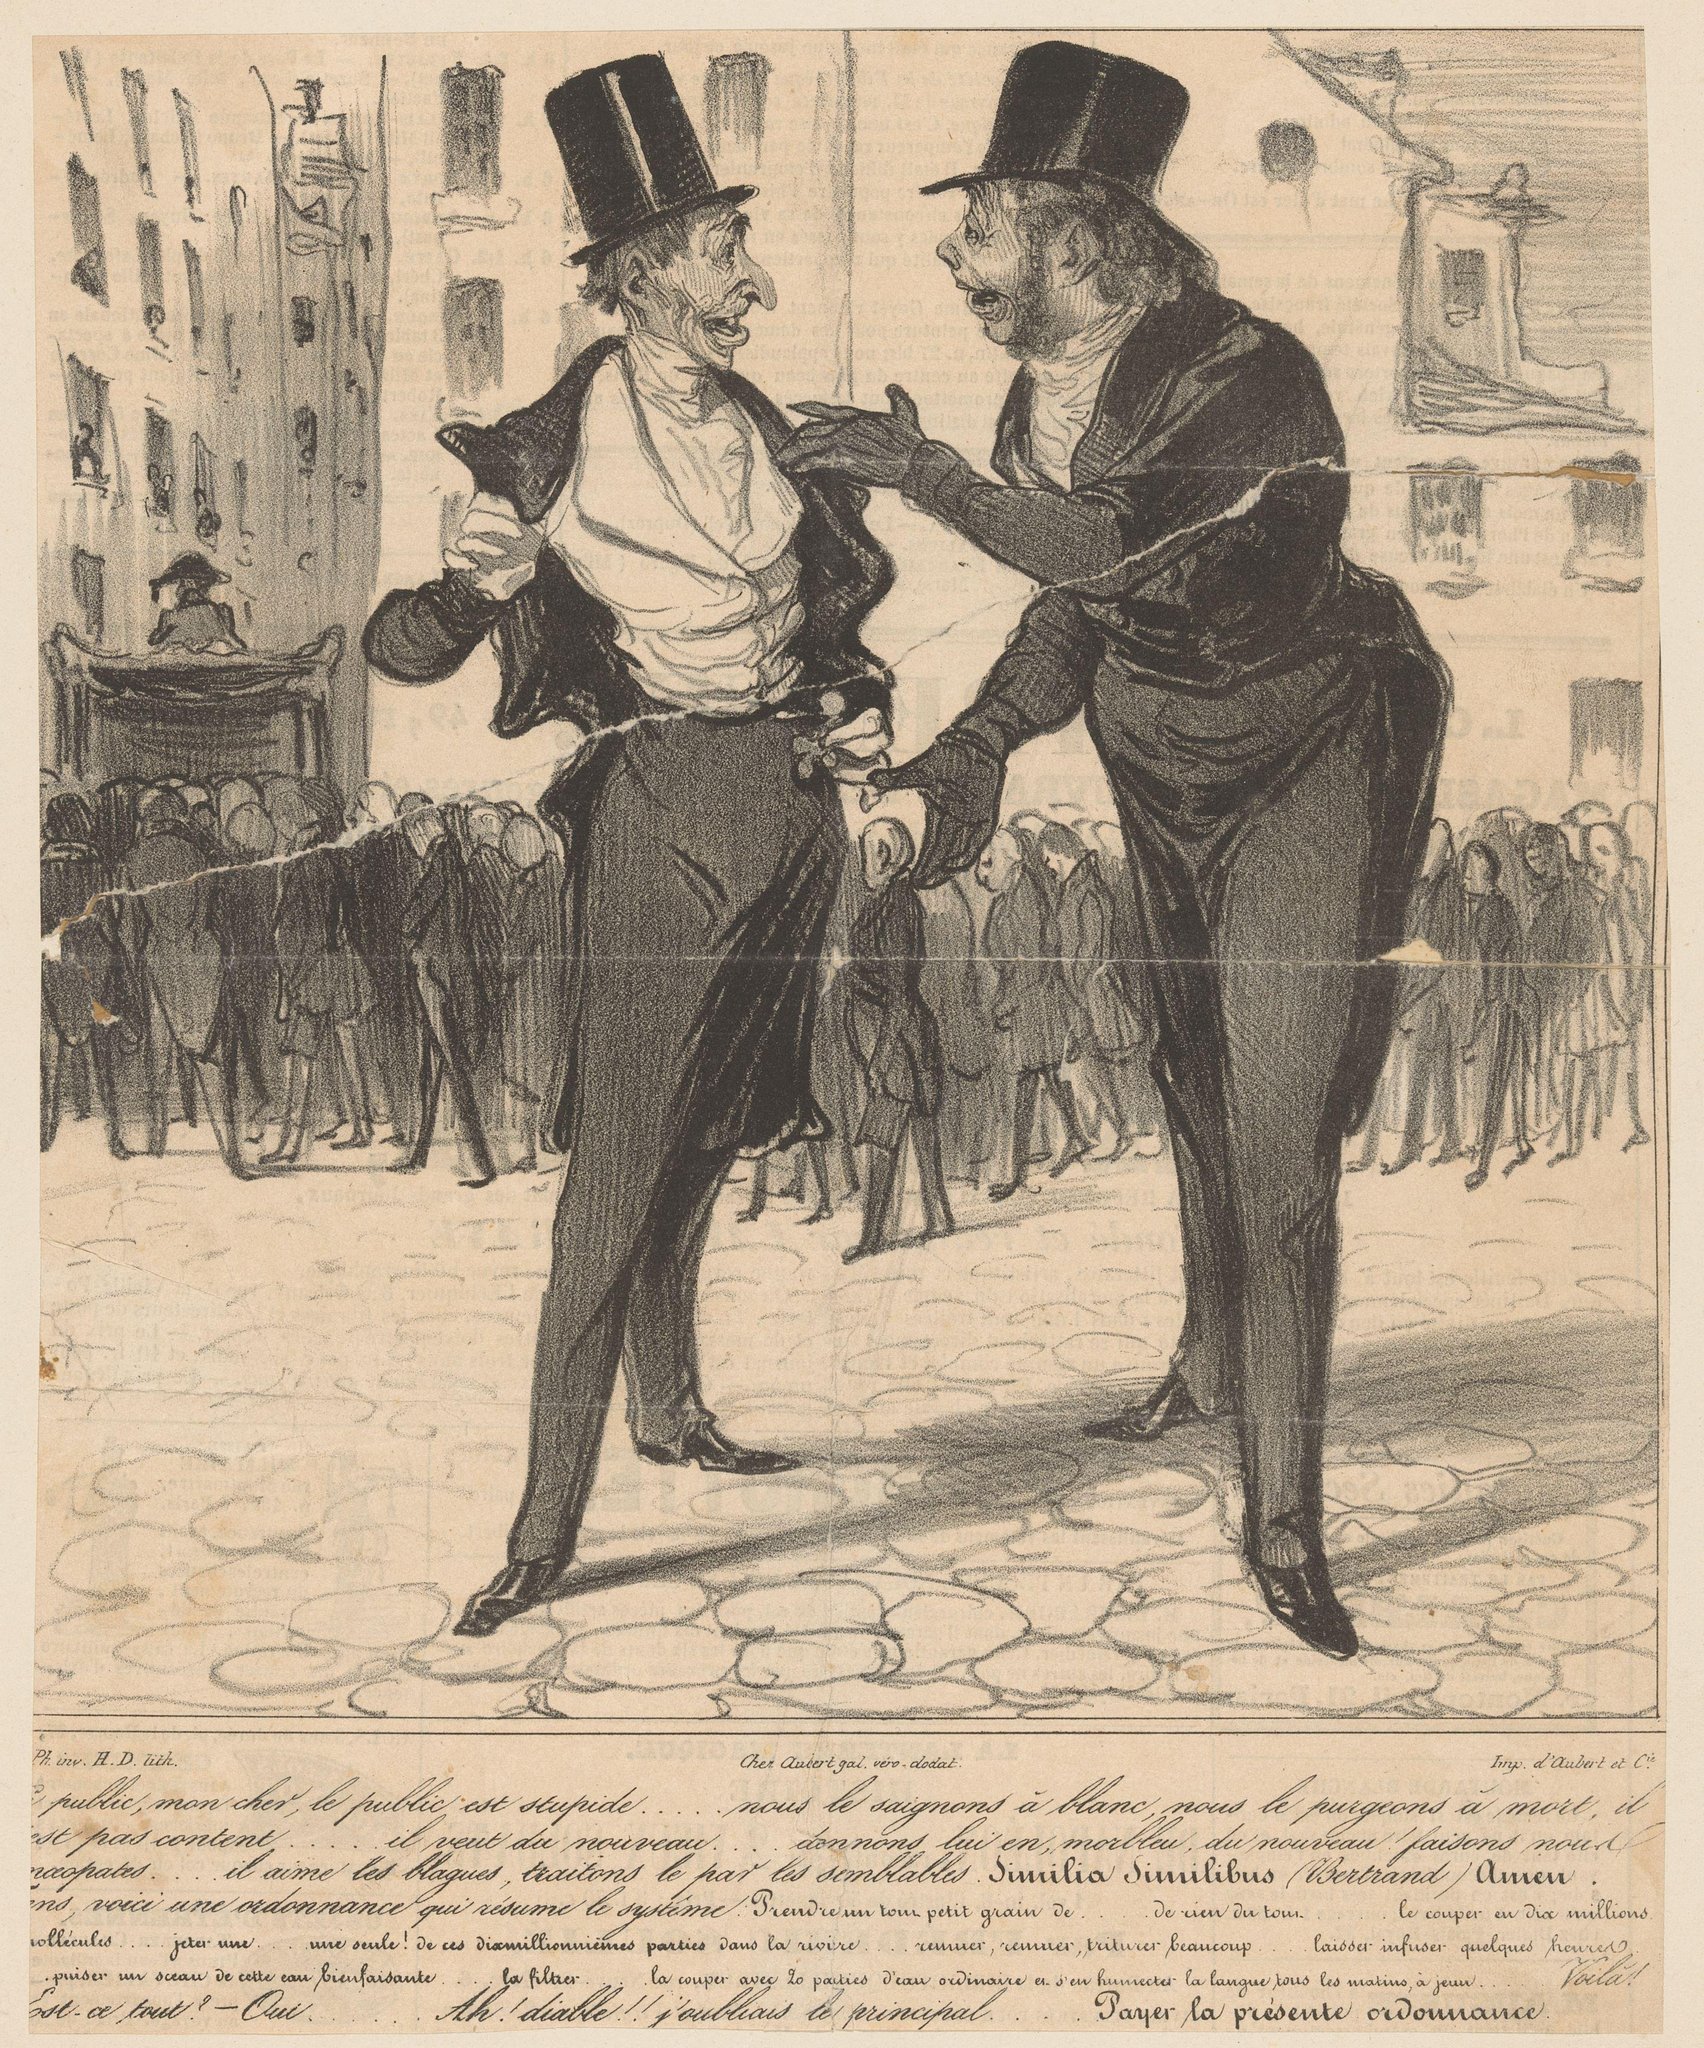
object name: cartoon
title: Karikaturen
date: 1837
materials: paper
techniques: letterpress printing, lithograph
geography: paris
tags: caricatures (human types), quack, charlatan, mountebank, 'saltimbanco', cortege, funeral procession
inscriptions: collector's mark: Lugt 2228a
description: Prent mogelijk uit: Le Charivari, 24 december 1837.